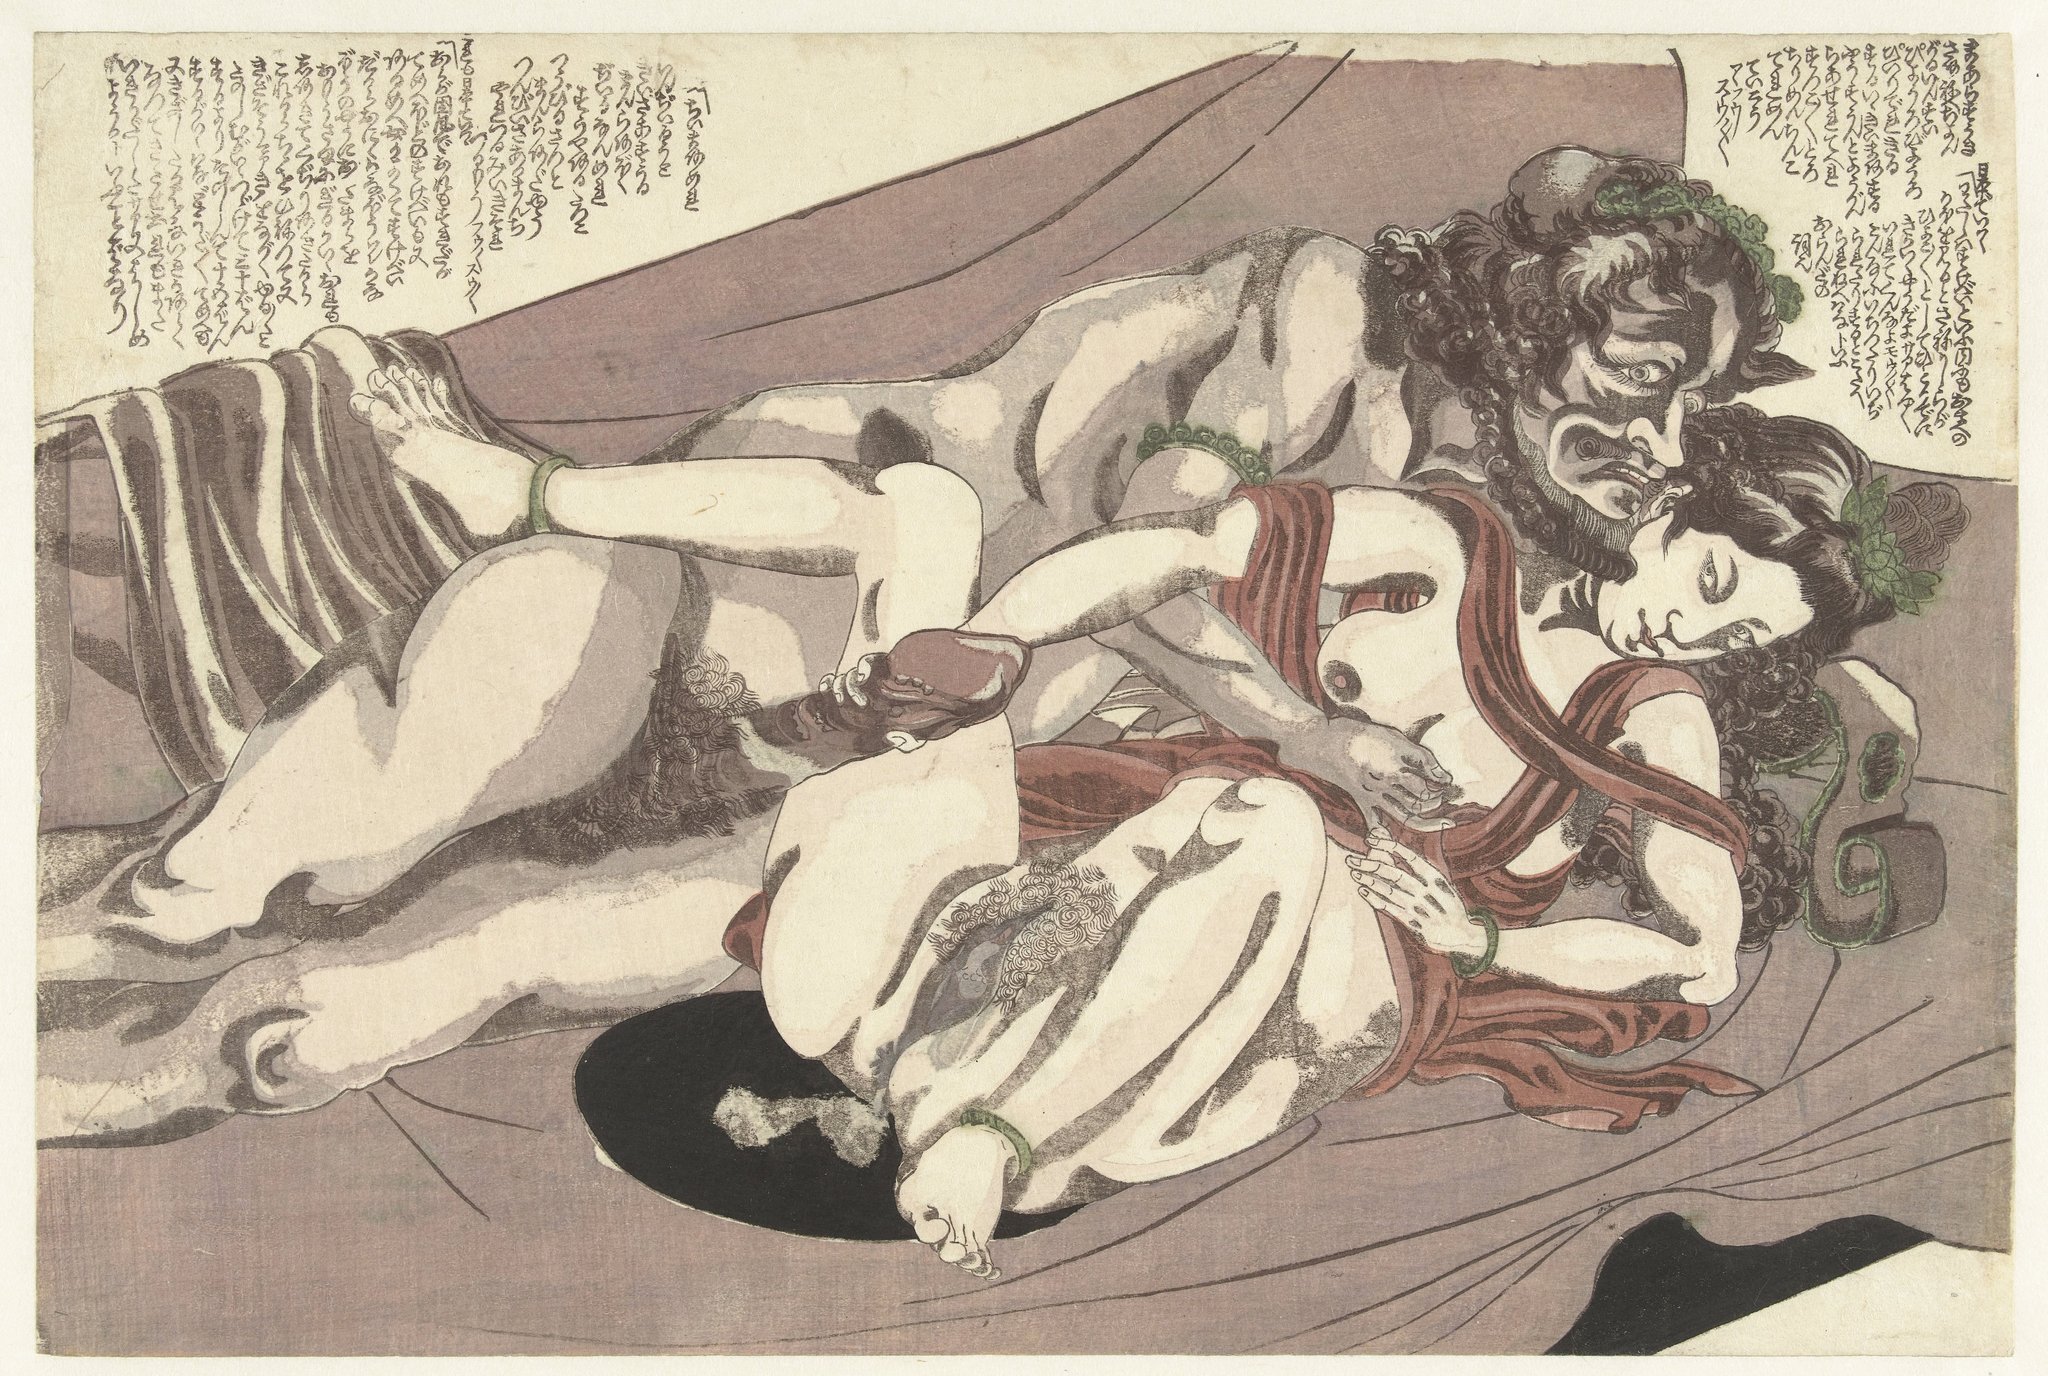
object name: print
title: Satyr en nimf bedrijven de liefde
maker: yanagawa shigenobu (i)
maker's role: draughtsman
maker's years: 1787-1832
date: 1825-1830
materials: paper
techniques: woodcut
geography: japan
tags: coitus, cohabiting, sexual intercourse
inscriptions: collector's mark: Lugt 2228, collector's mark: Lugt 2760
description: Naakte satyr bedrijft de liefde met nimf in rood gewaad. Tekst in de linker en rechter bovenhoek.